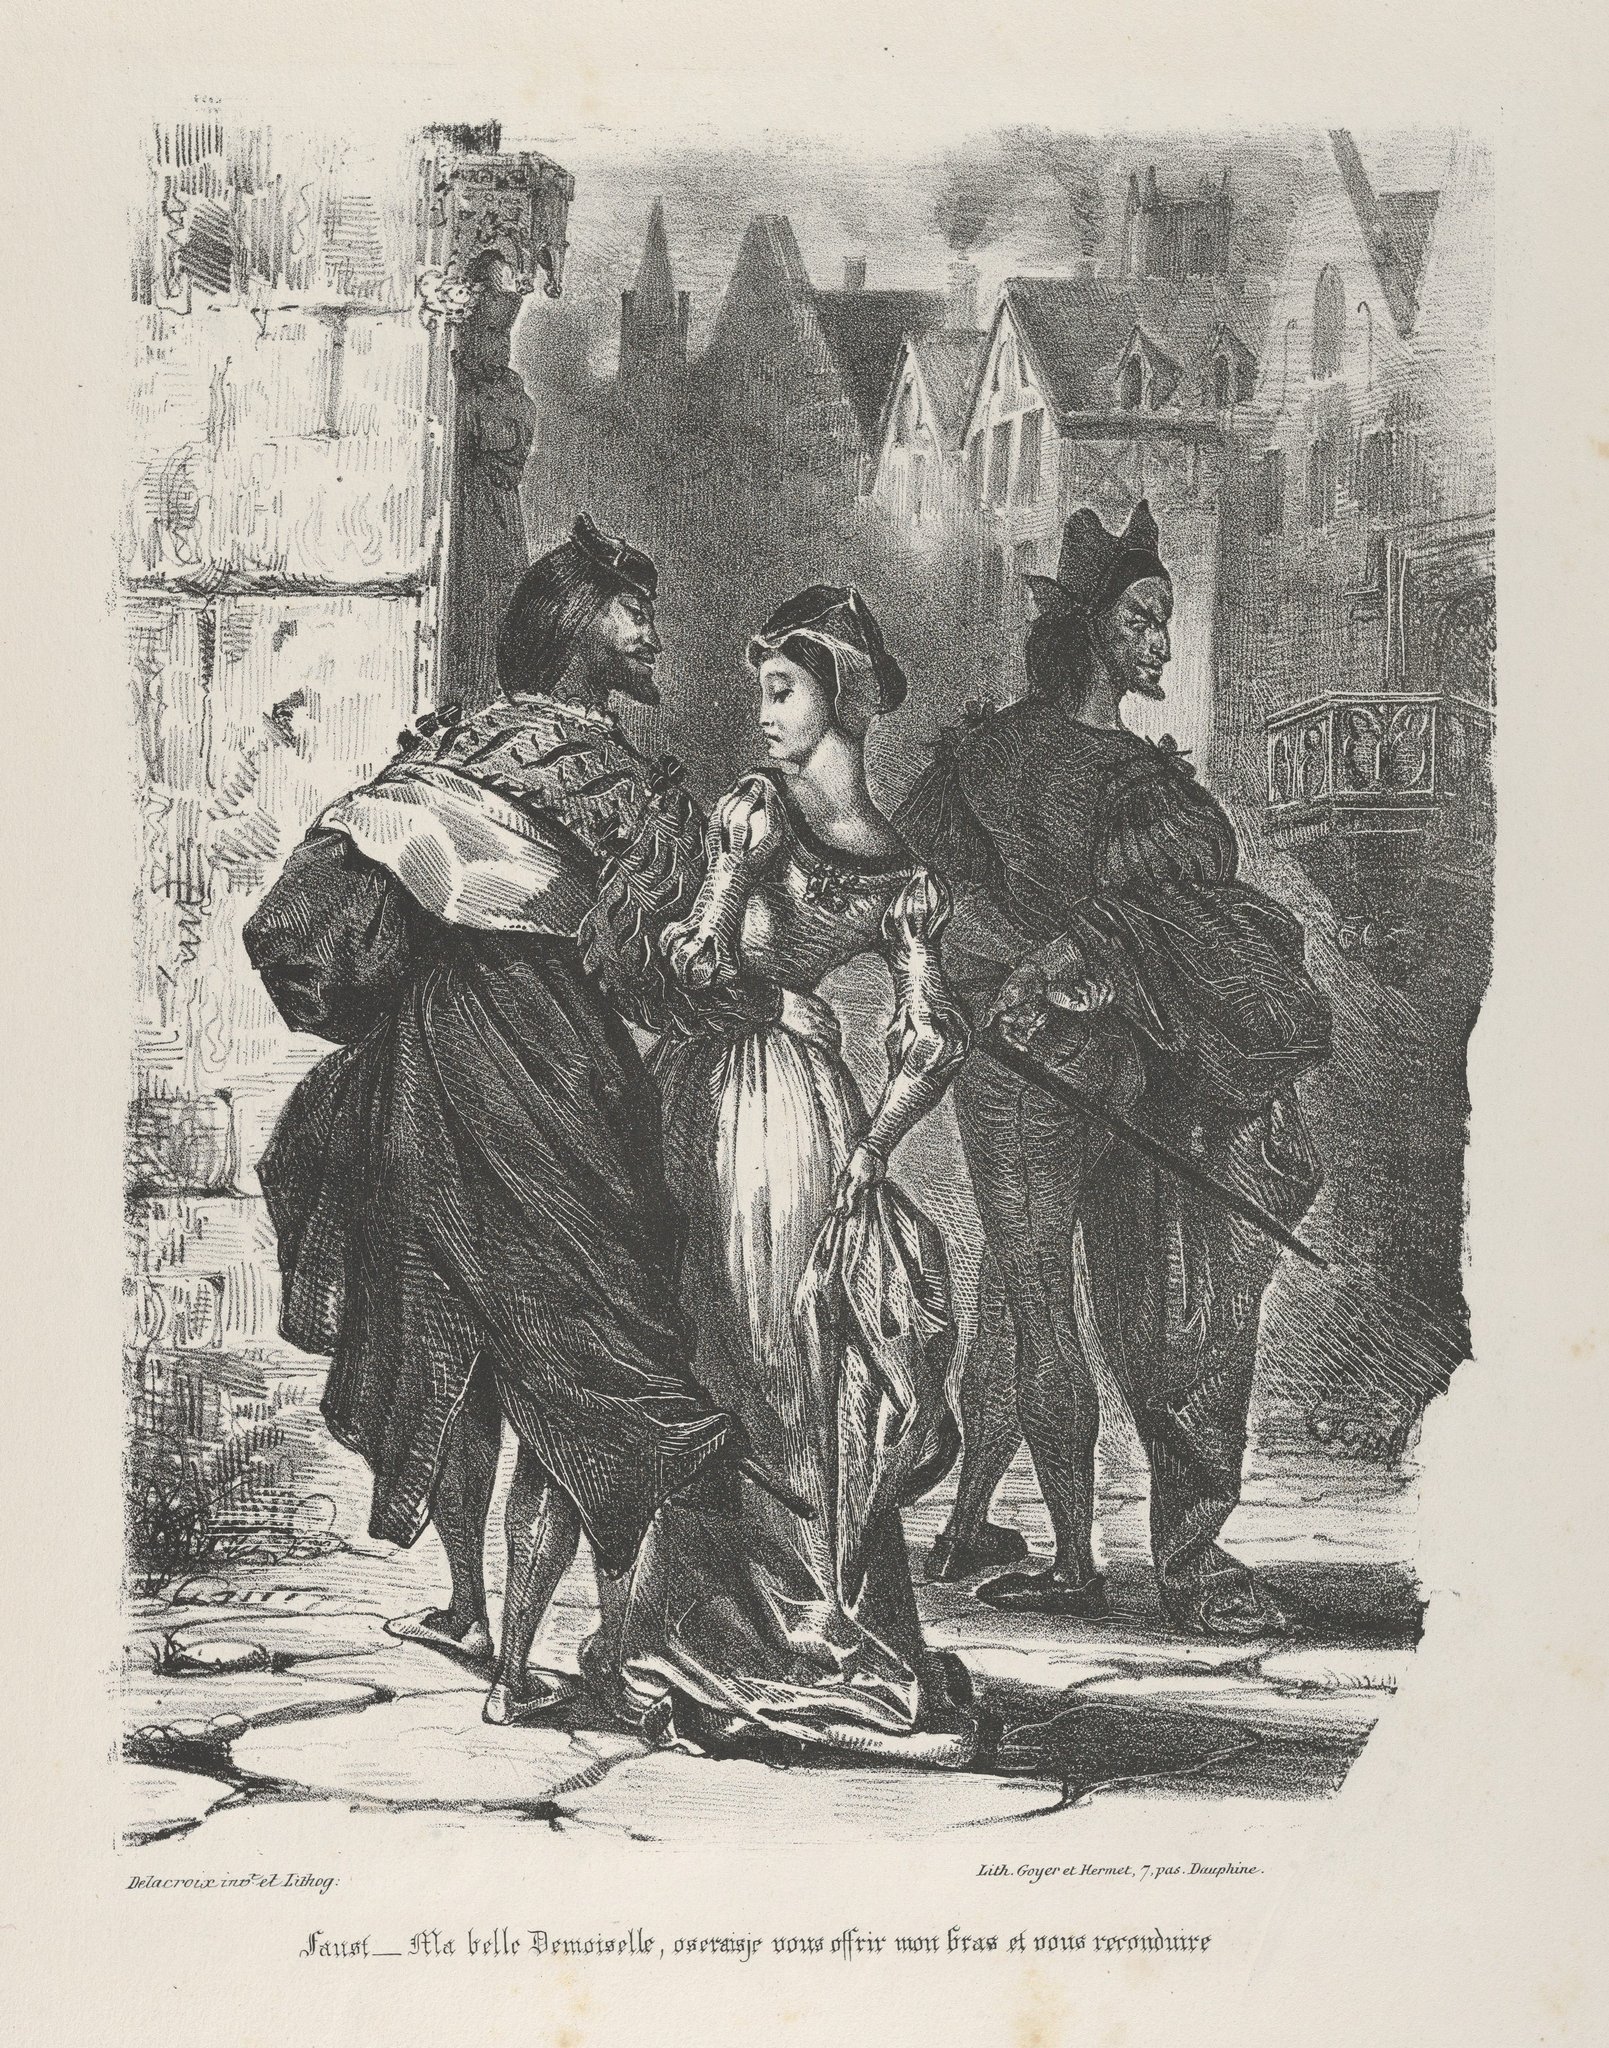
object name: print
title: Faust Trying to Seduce Marguerite (Goethe, Faust)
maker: eugène delacroix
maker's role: artist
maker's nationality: french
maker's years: 1798-1863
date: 1825-1827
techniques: lithograph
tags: men,women